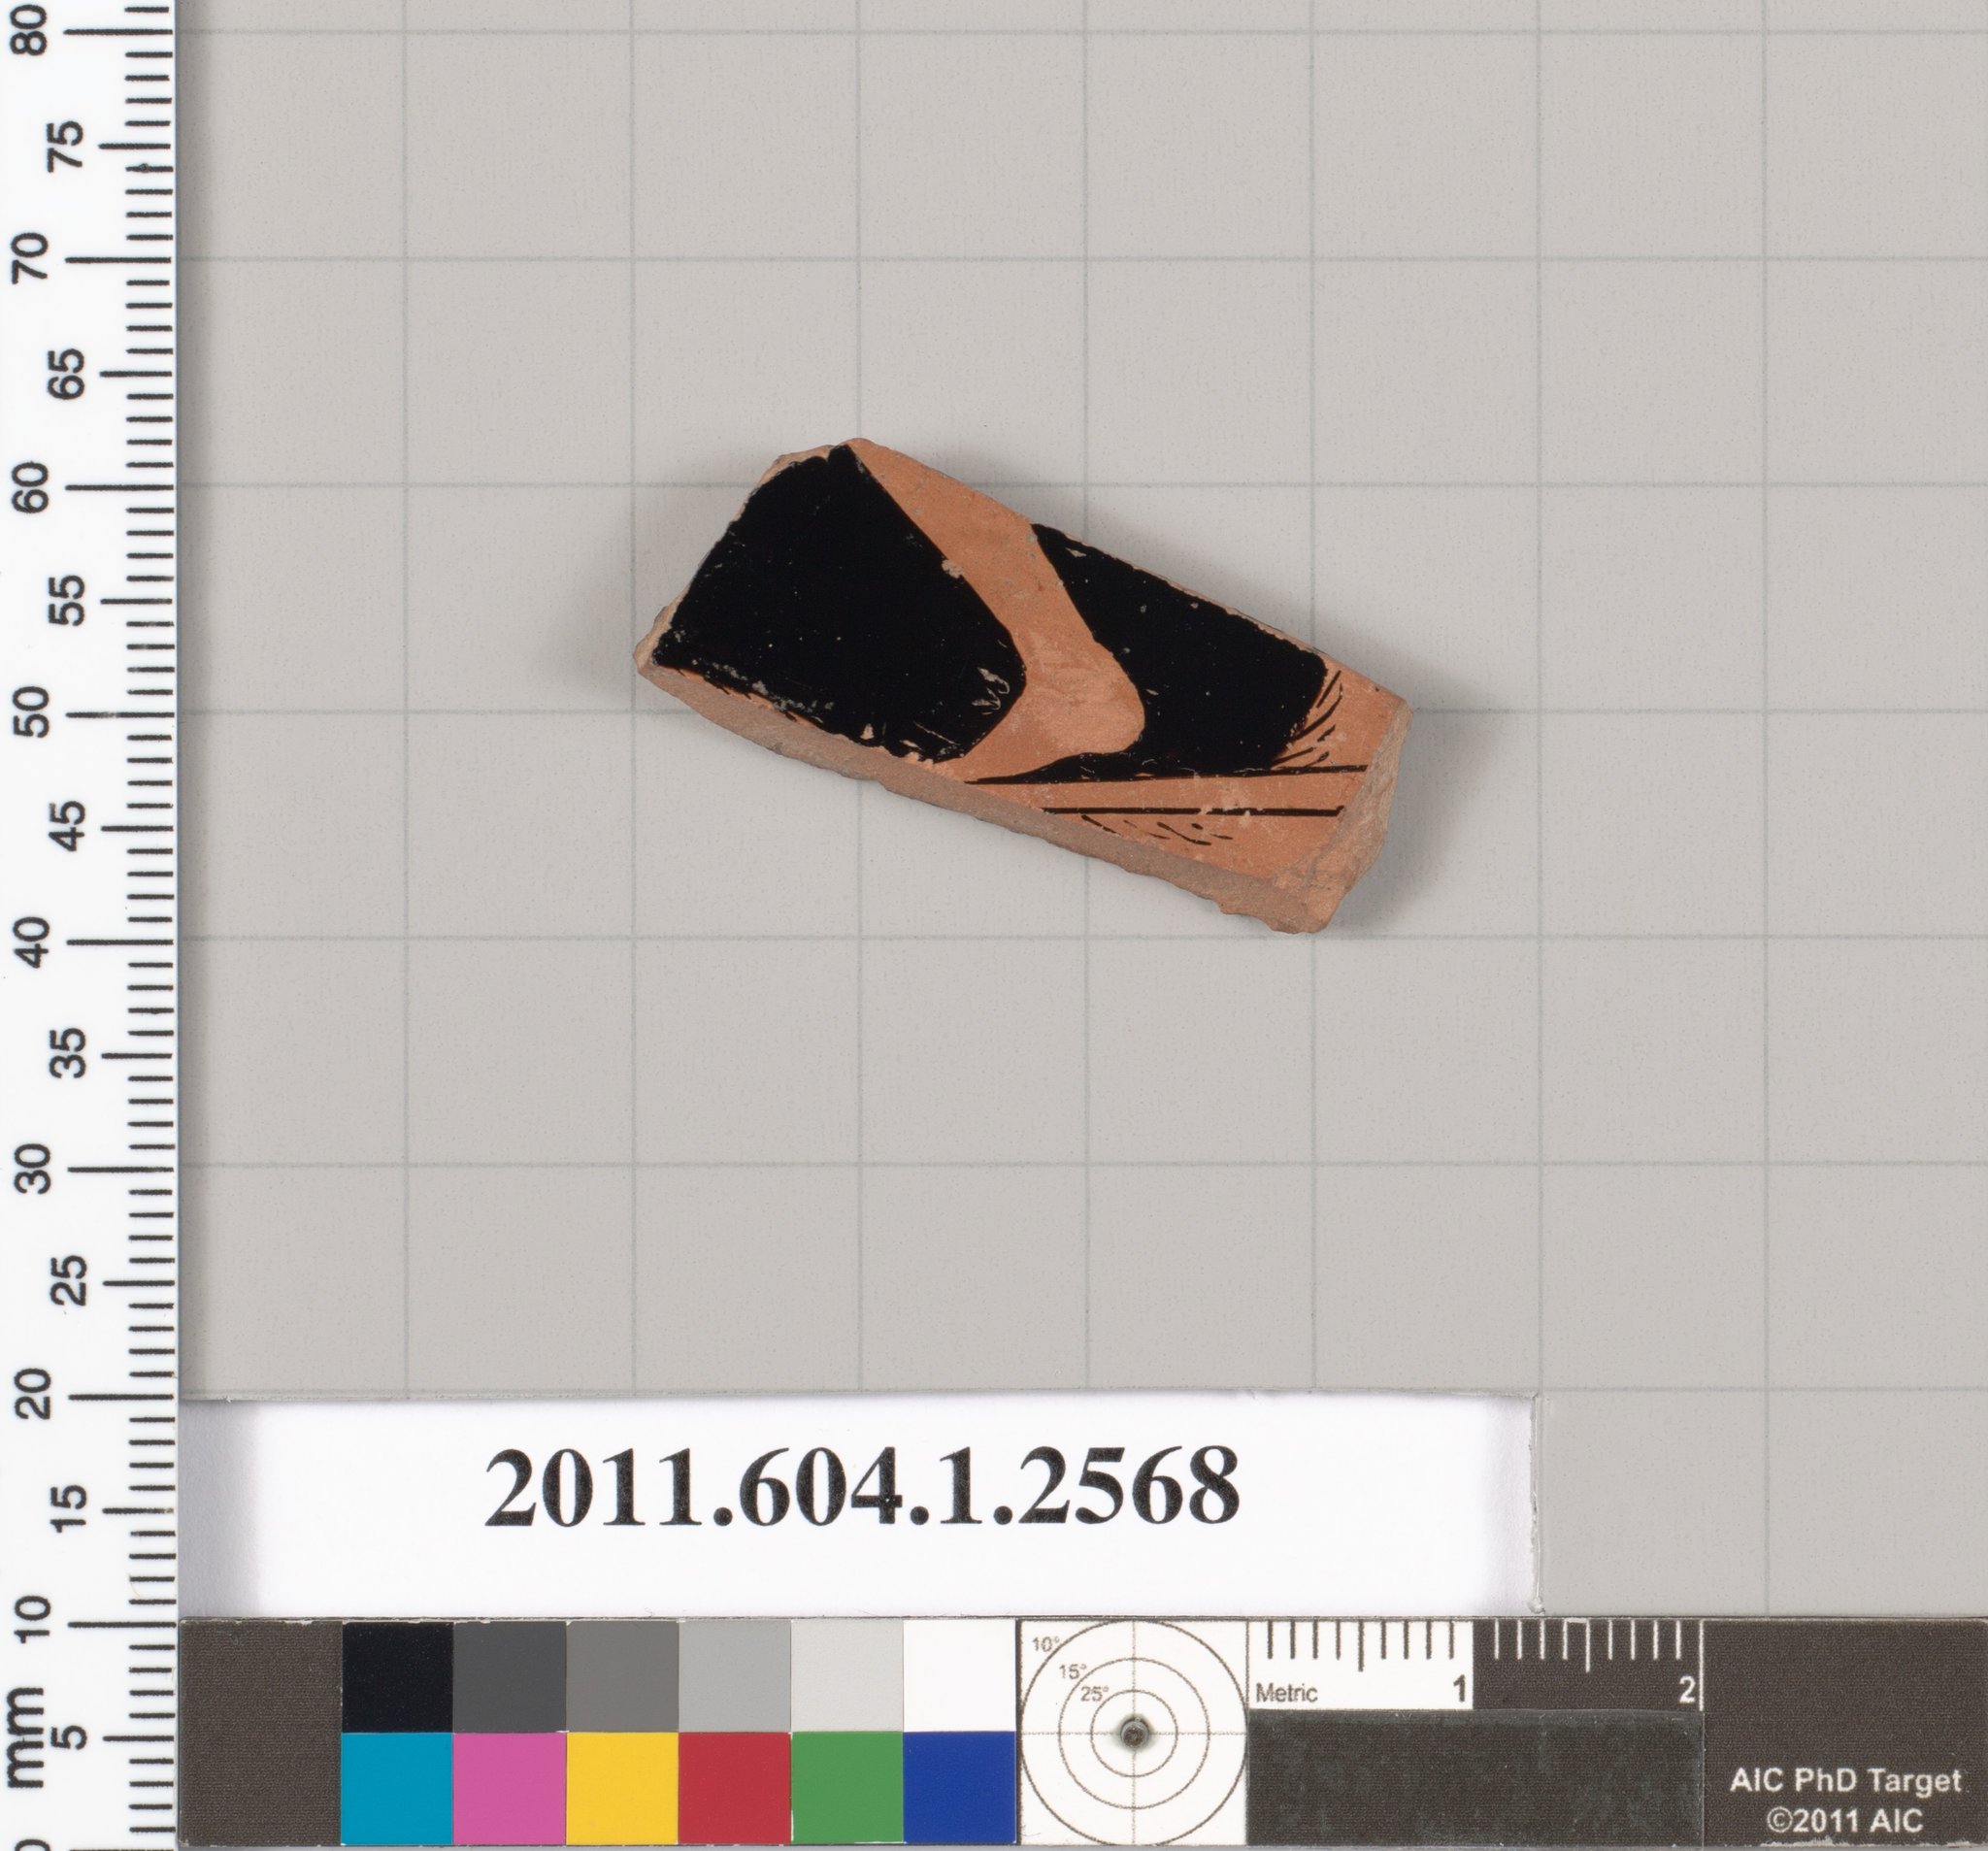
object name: kylix fragment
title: Terracotta fragment of a kylix (drinking cup)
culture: greek, attic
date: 475-451 BCE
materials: terracotta